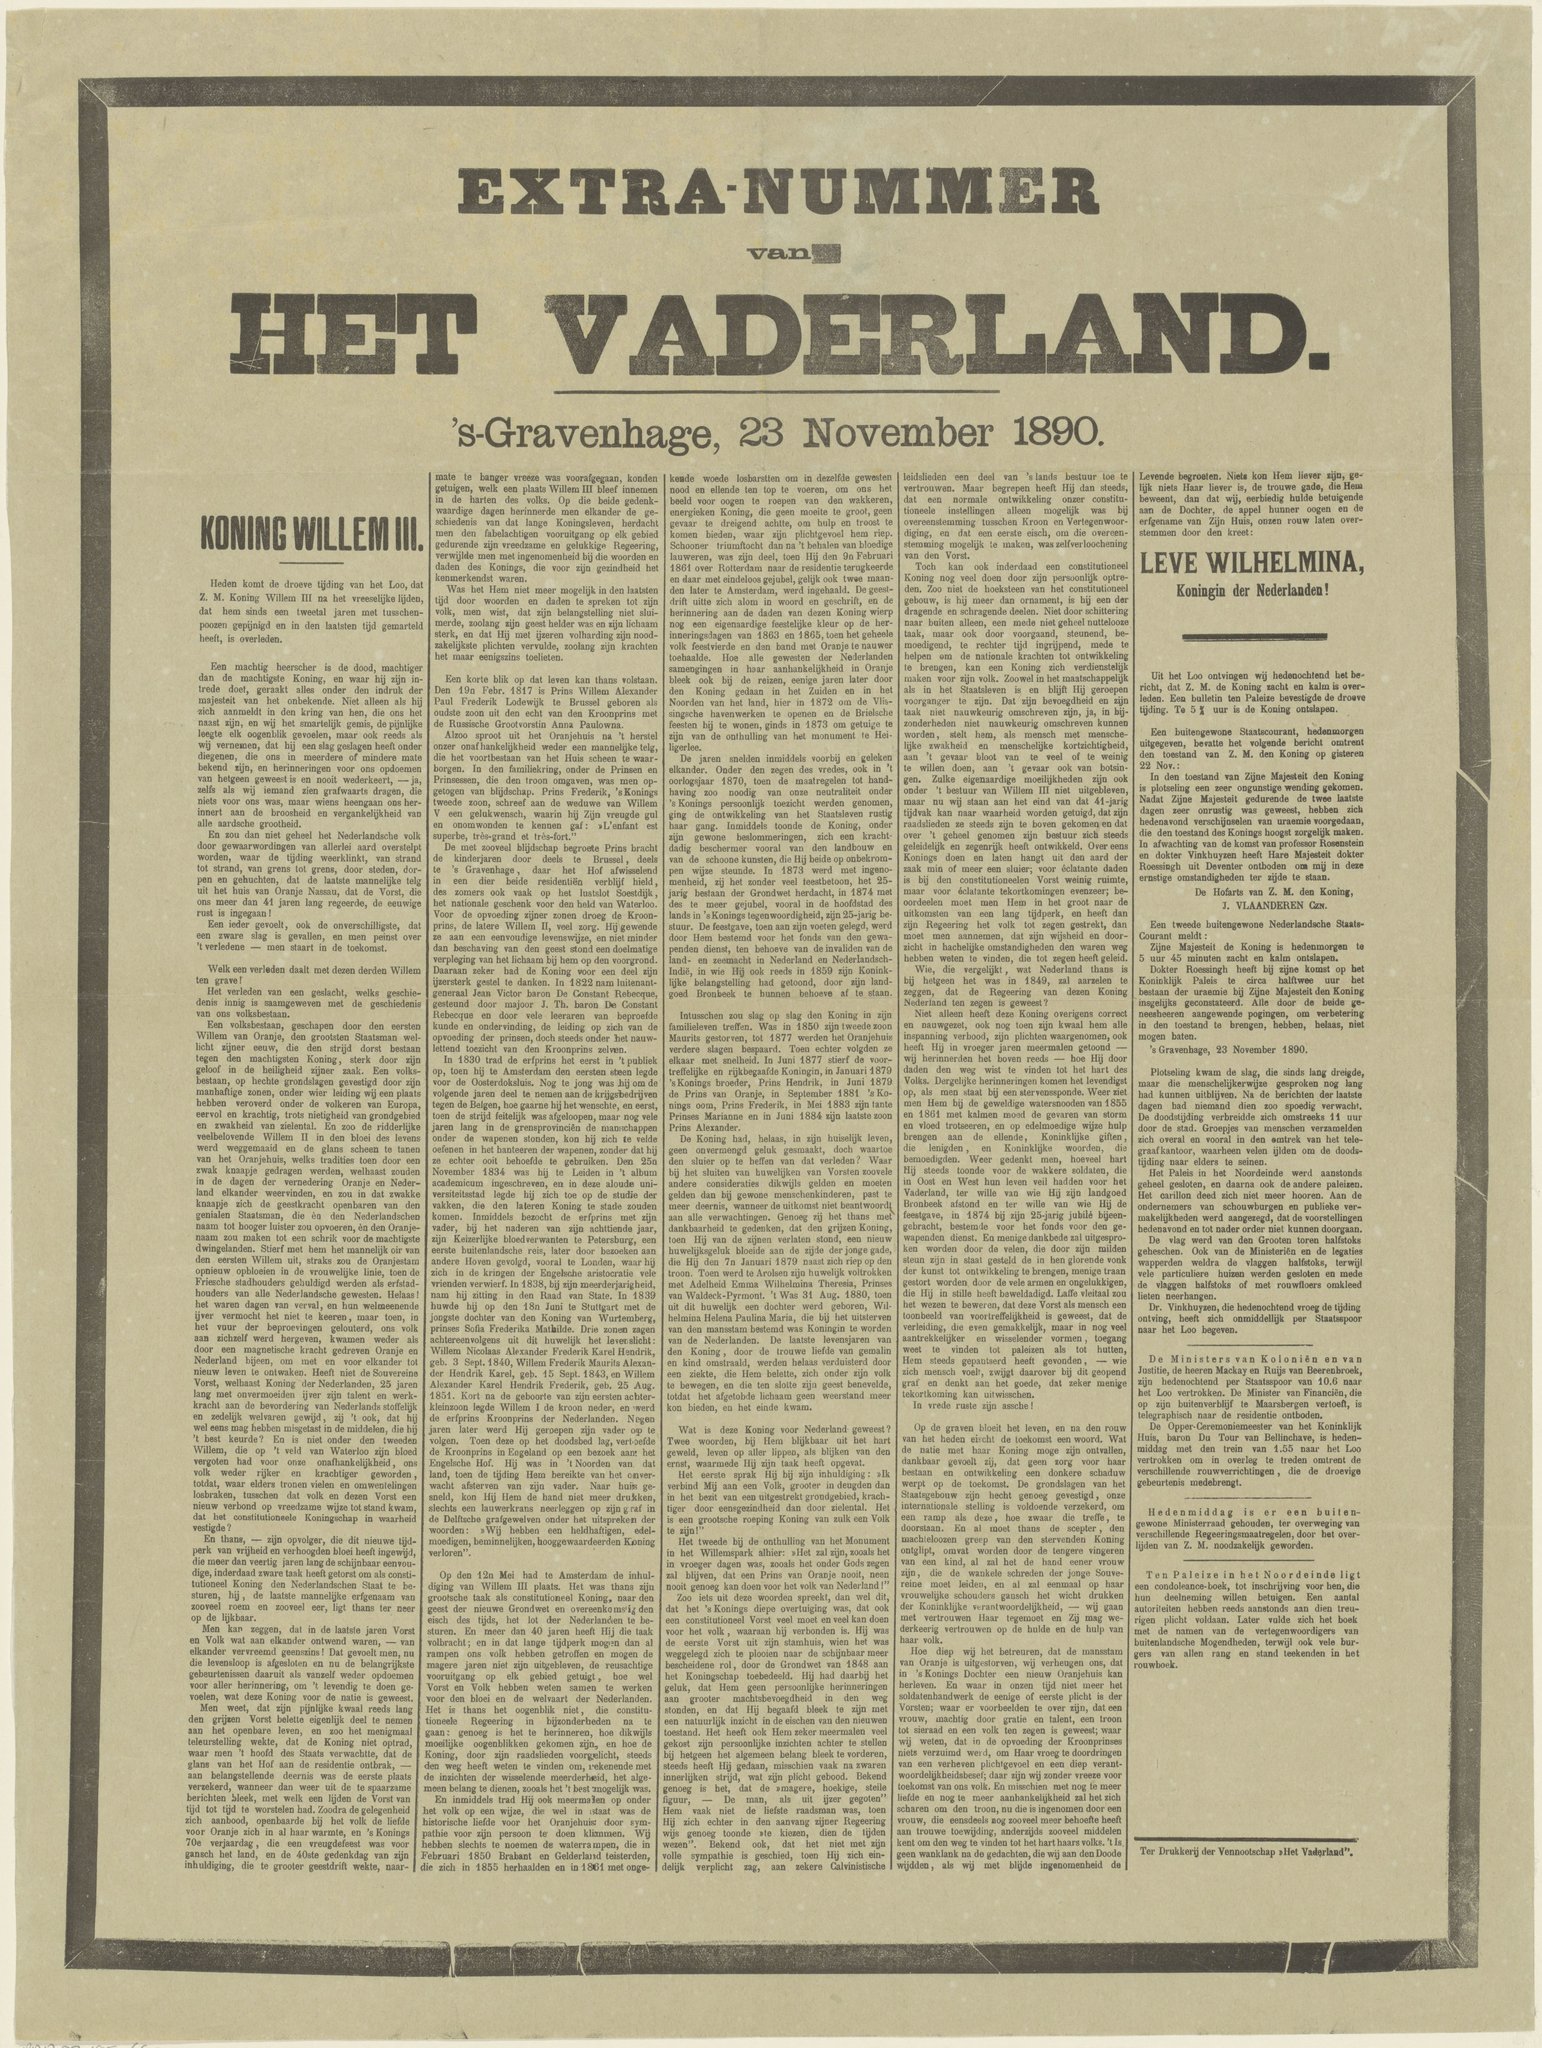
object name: newspaper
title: Extra-nummer van Het Vaderland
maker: Anonymous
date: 1890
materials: paper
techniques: letterpress printing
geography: netherlands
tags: willem iii (koning der nederlanden)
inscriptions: date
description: Extra nummer over het overlijden van Willem III in Paleis Noordeinde te Den Haag op 23 november 1890.